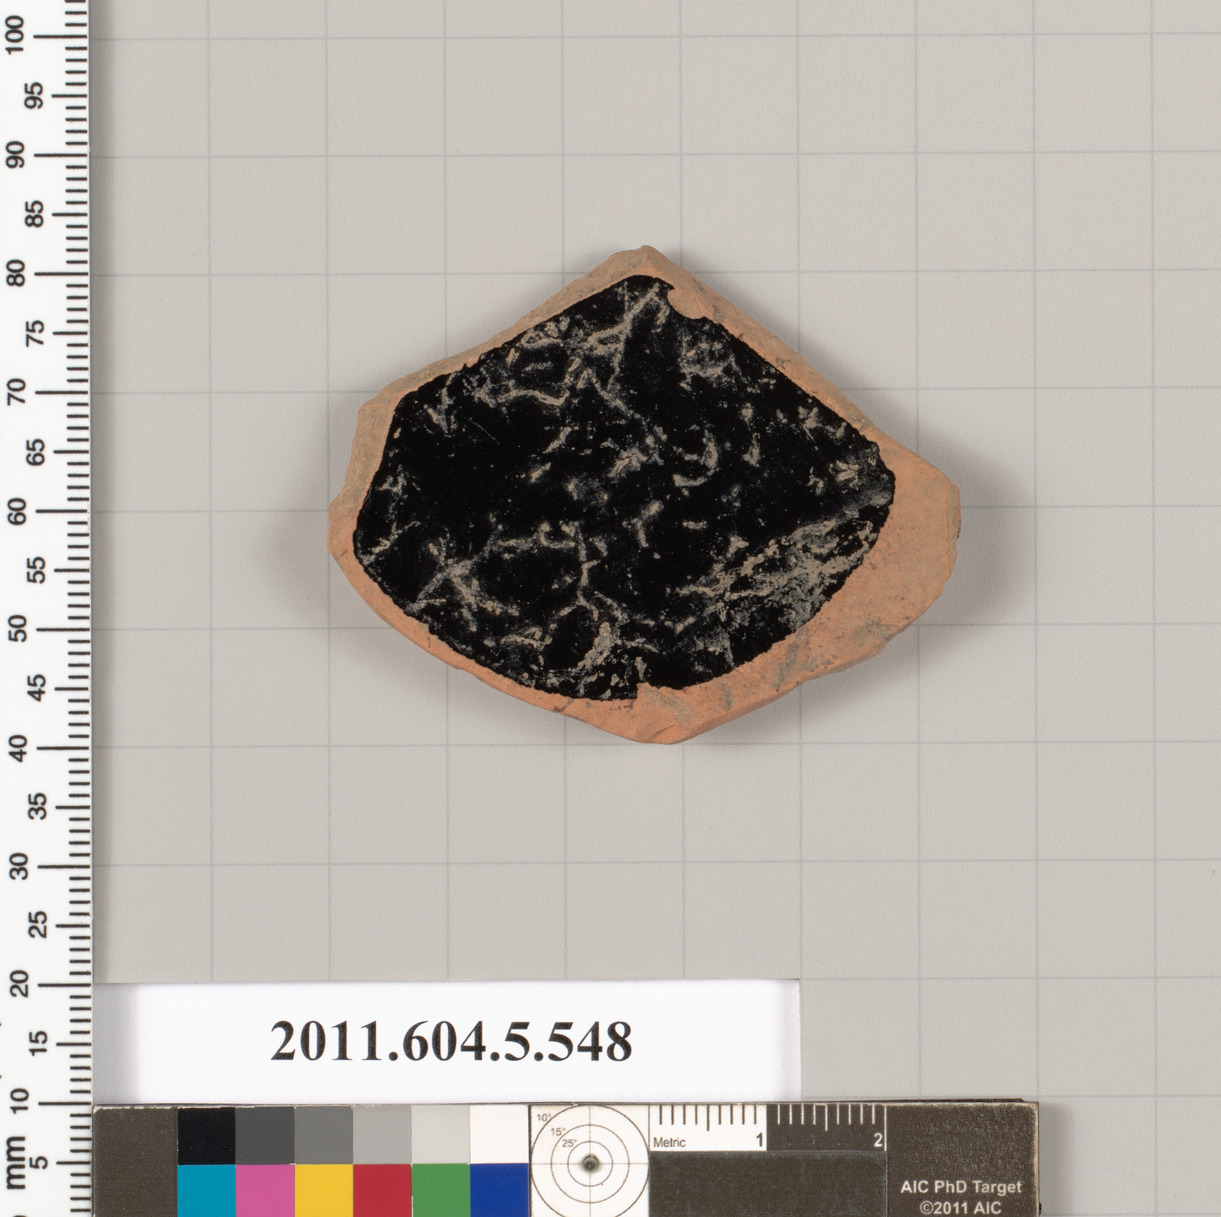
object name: kylix fragment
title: Terracotta fragment of a kylix (drinking cup)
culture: greek, attic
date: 600-401 BCE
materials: terracotta